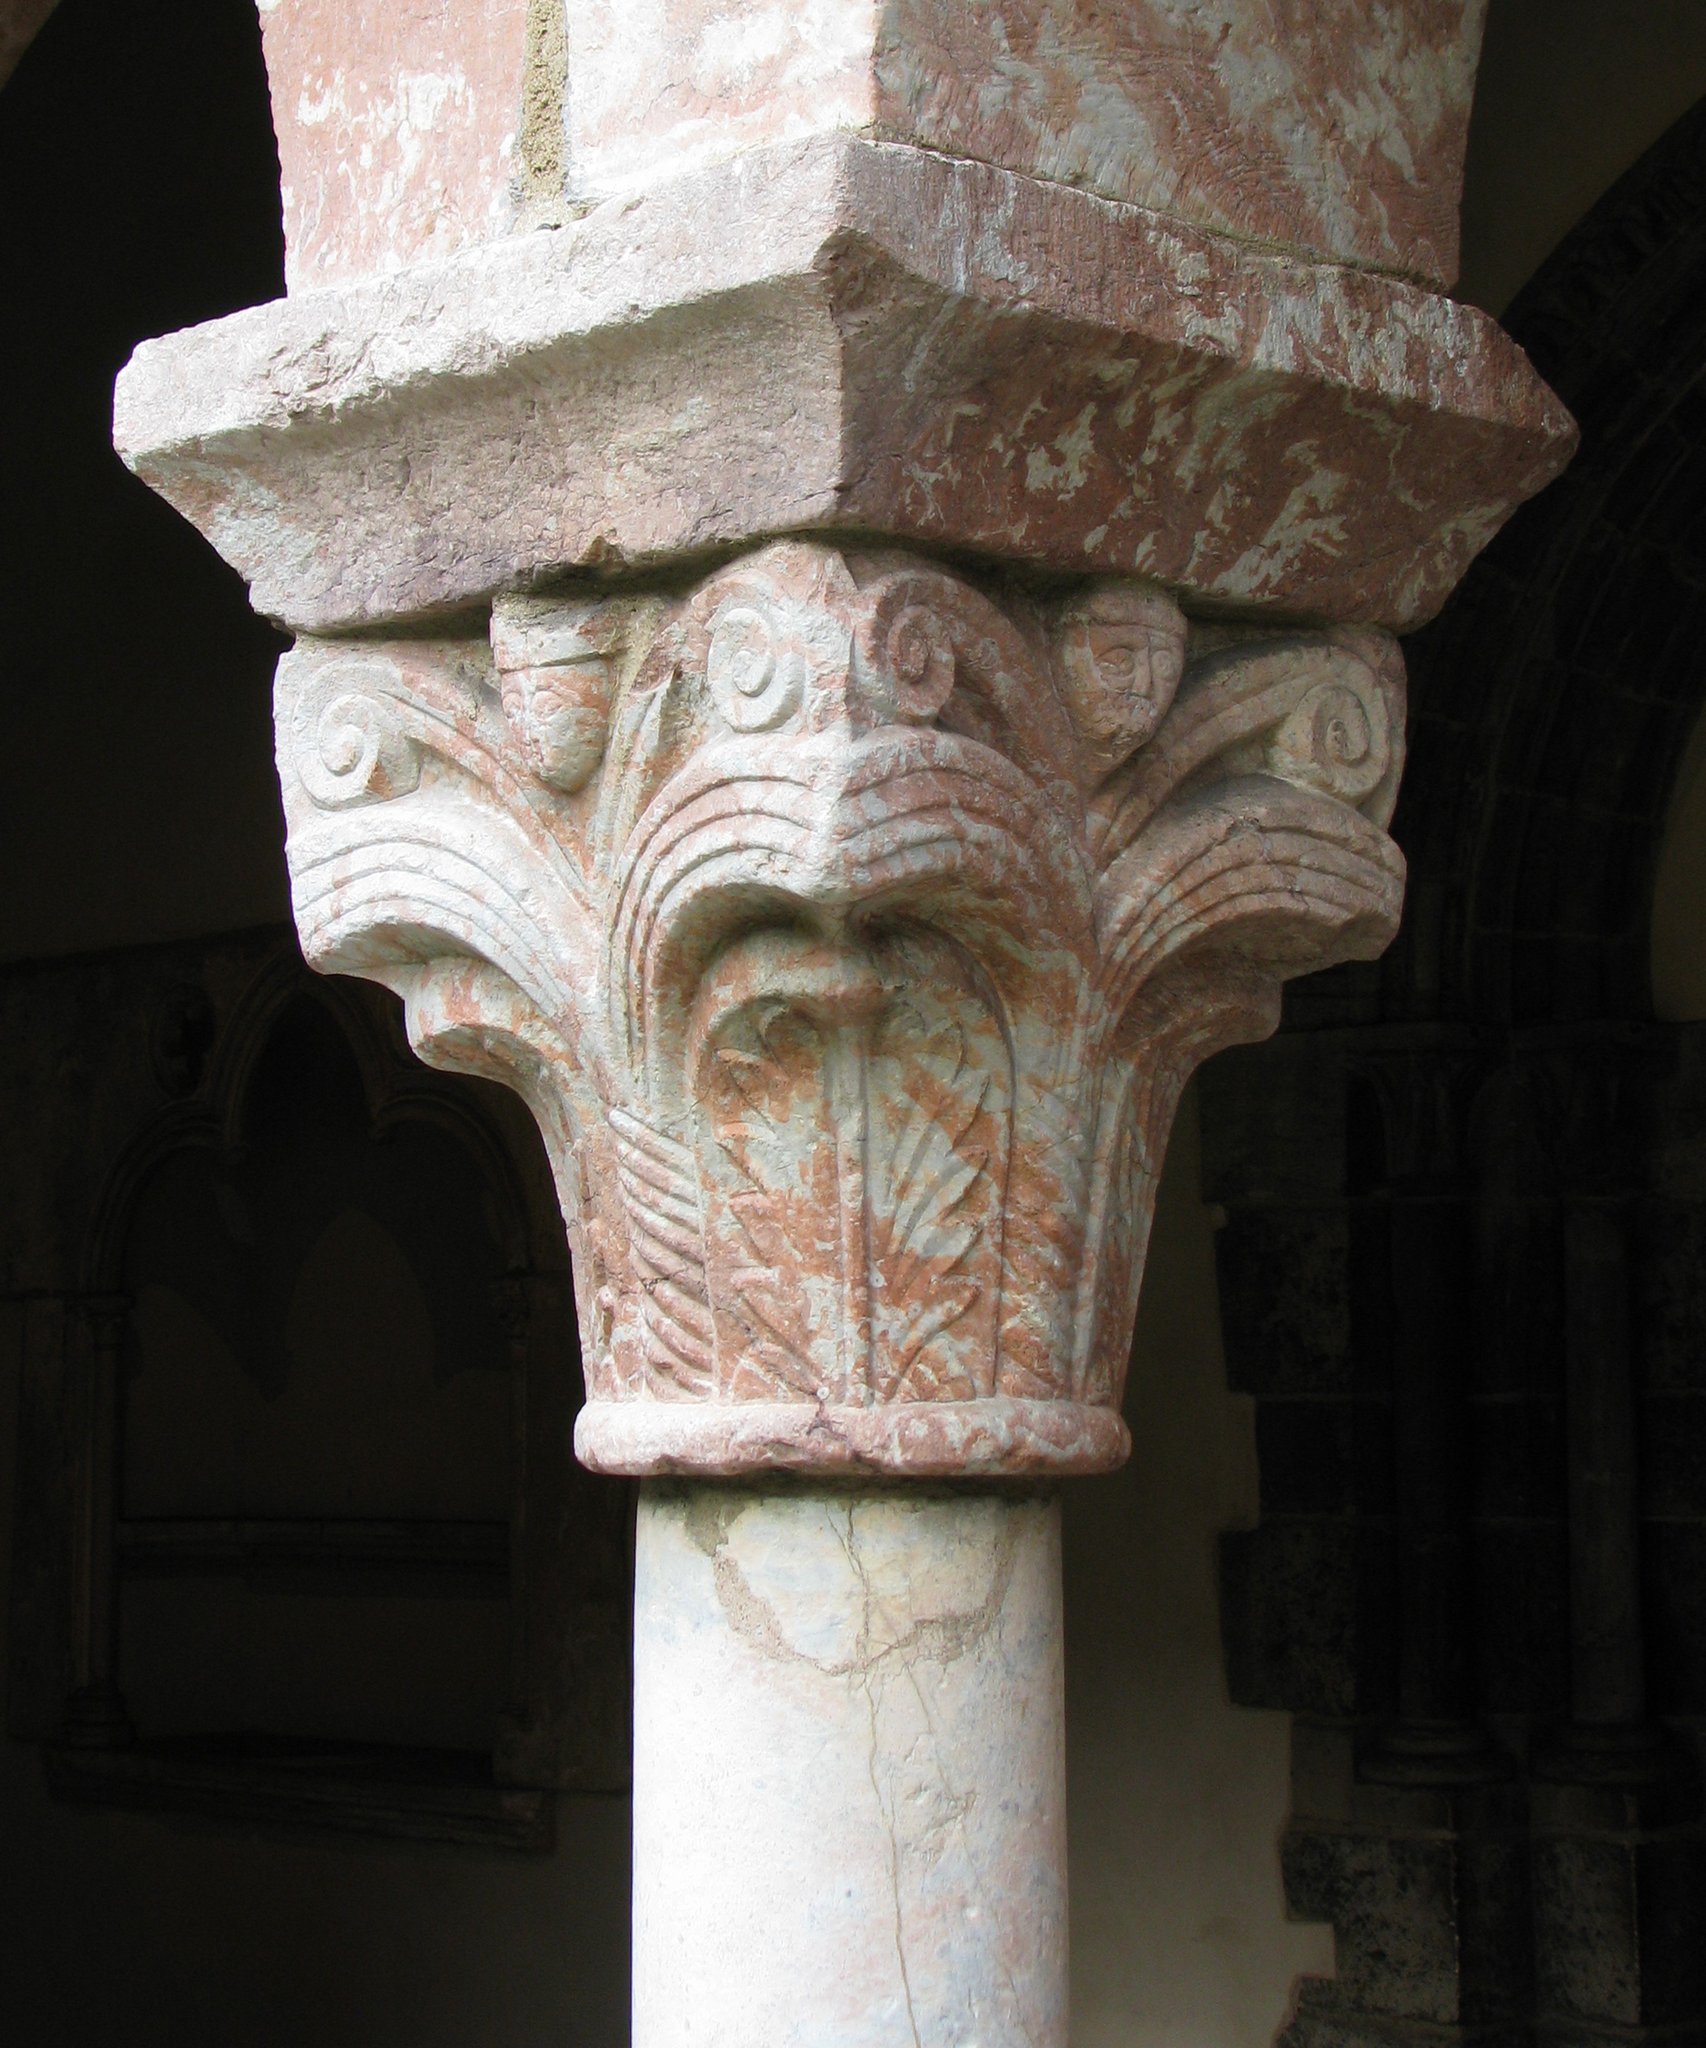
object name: capital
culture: catalan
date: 1130-1140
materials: marble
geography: france